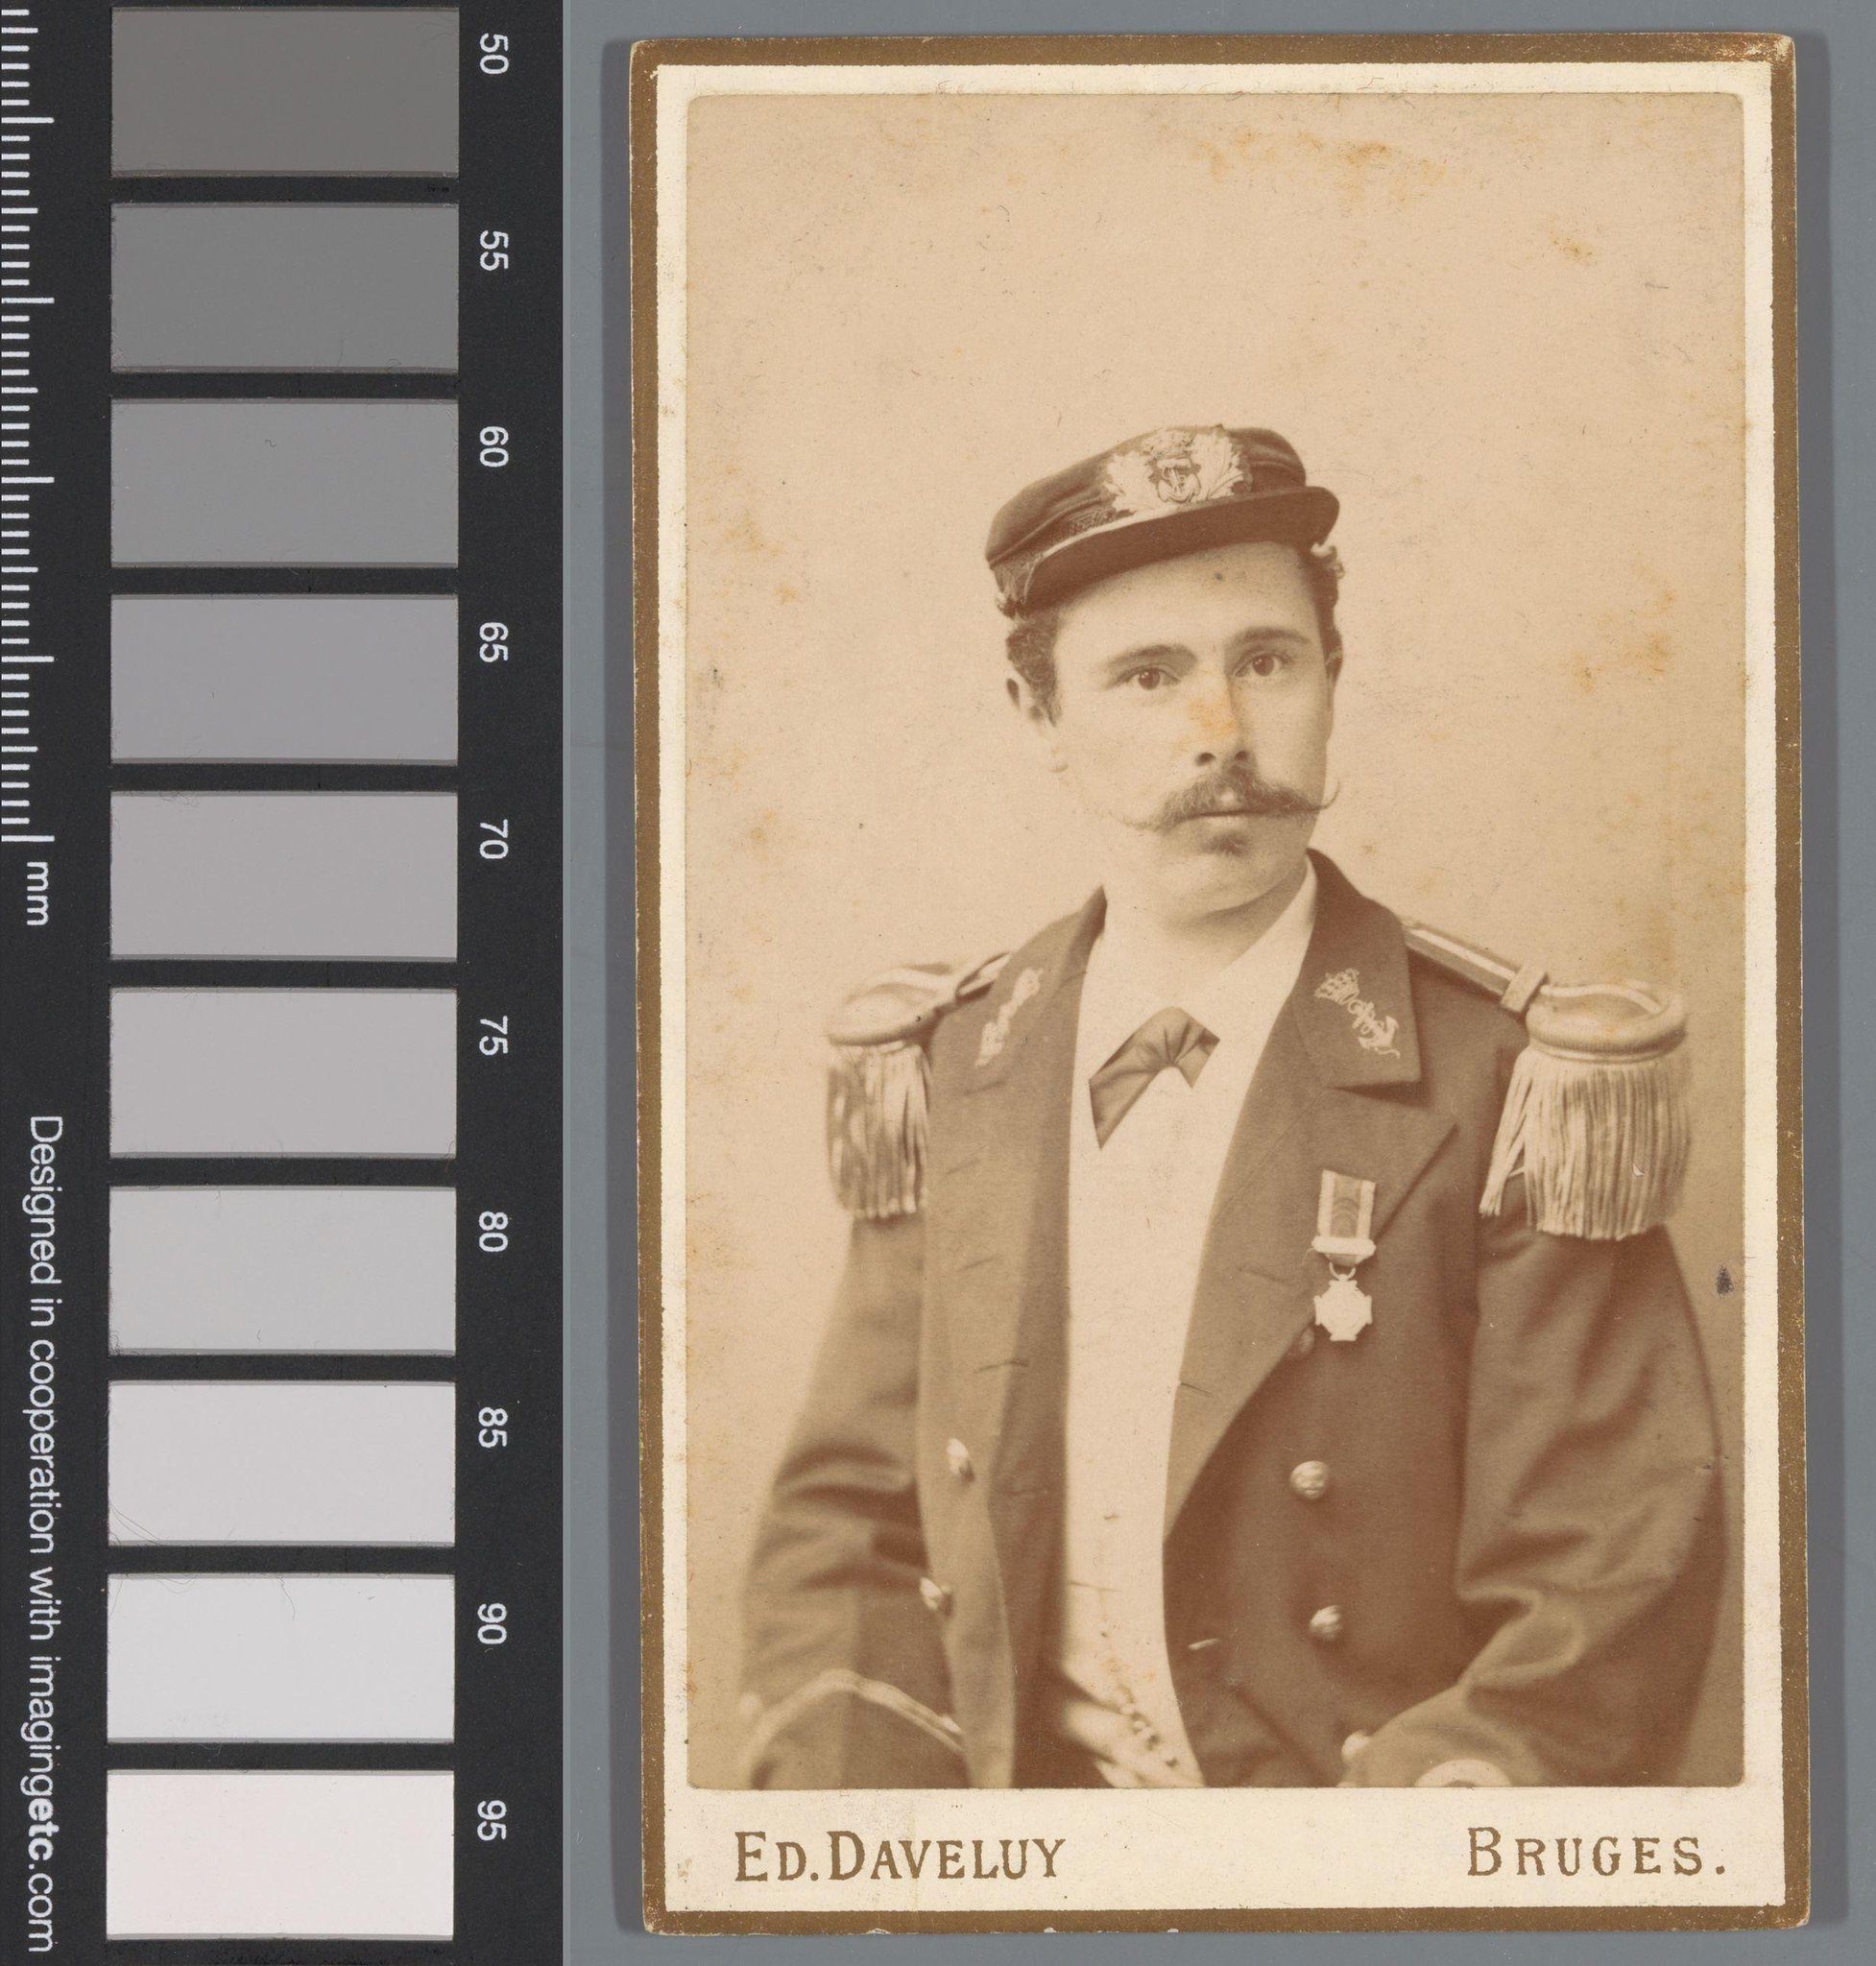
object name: photograph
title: Portret van een onbekende man in marine-uniform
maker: edouard-alexis daveluy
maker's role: print maker, printer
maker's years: 1812-1894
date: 1860-1865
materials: cardboard, paper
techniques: albumen print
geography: bruges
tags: adult man, anonymous historical person portrayed, (military) uniforms, bruges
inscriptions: inscription: ‘Photographie Artistique/ Edouard Daveluy/ Successeur de/ Victor Davelut/ Quai Vert/ Bruges./ Les clichés sont conservés.’, inscription: ‘Ed. Daveluy Bruges.’